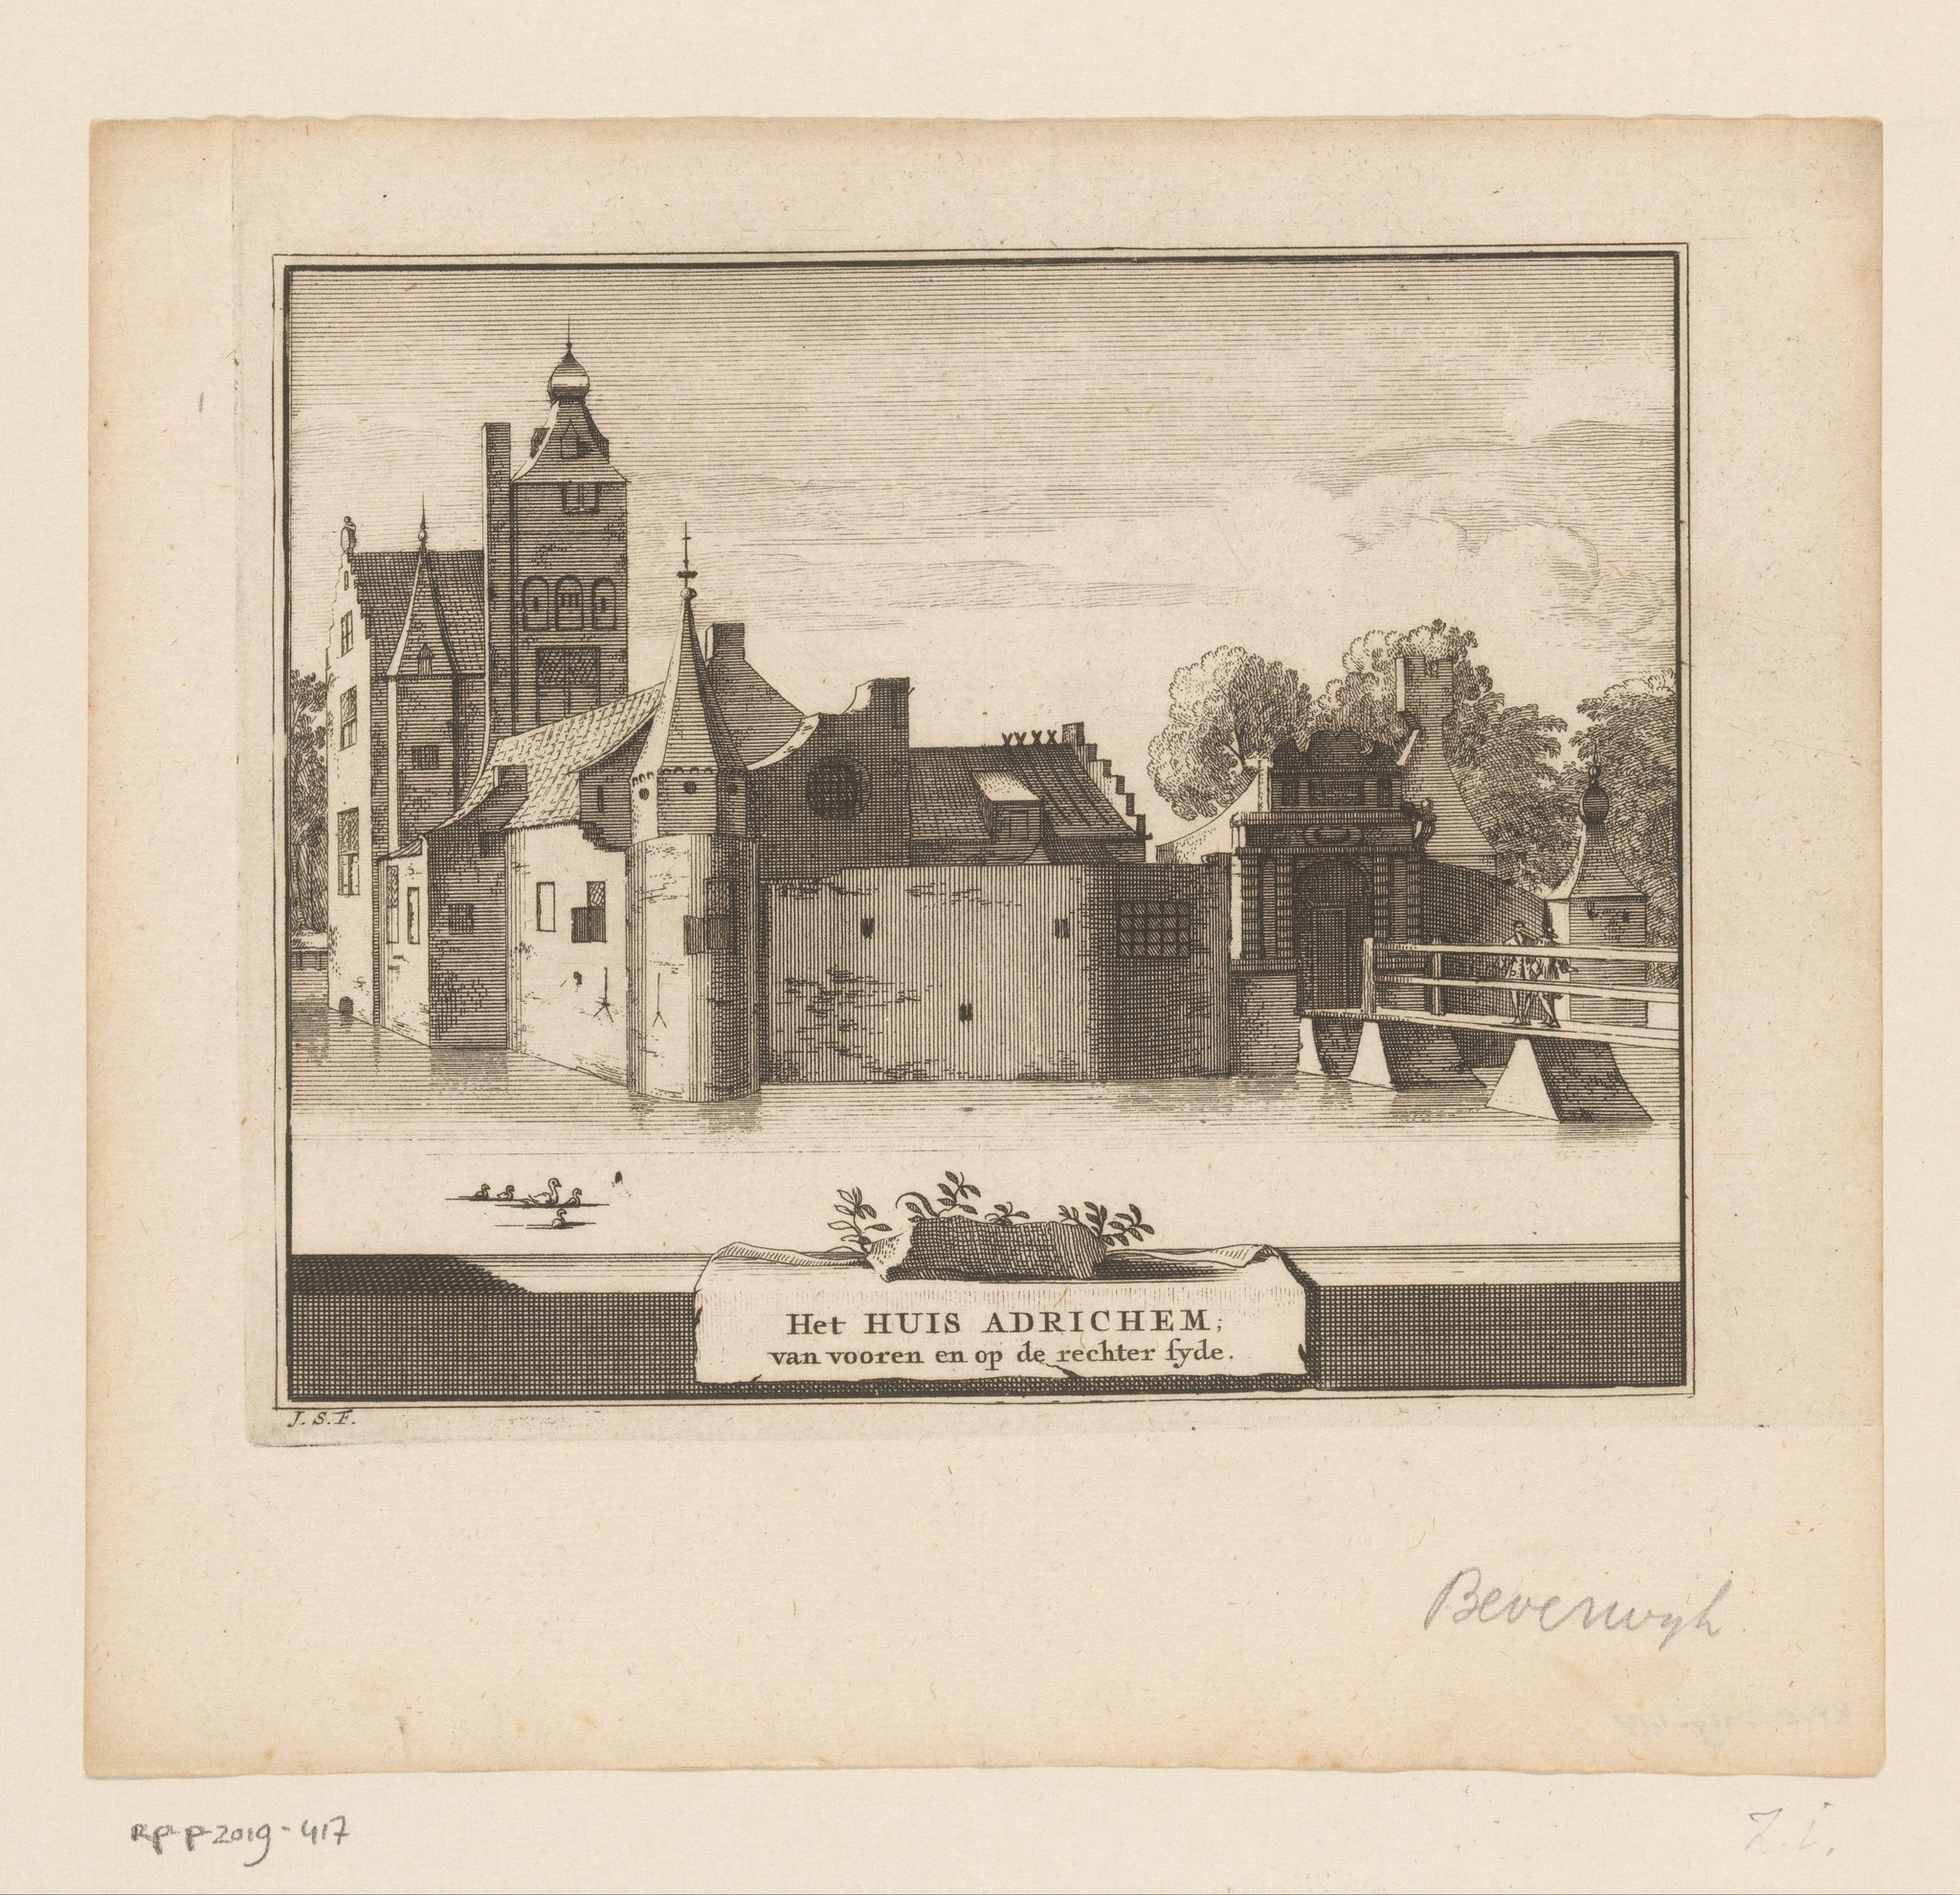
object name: print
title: Het Huis Adrichem, van vooren en op de rechter syde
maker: jacobus schijnvoet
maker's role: draughtsman, print maker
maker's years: 1685-1743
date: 1711-1774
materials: paper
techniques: etching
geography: amsterdam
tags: castle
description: Prent opgenomen in: Smids, Ludolph. Schatkamer der Nederlandsse[!] oudheden; of Woordenboek, behelsende Nederlands steden. Amsterdam: Pieter de Coup, 1711. Verscheen tevens in de heruitgave van voorgenoemd werk in 1737 en 1774. In 1721 verscheen er een uitgave met alleen de prenten: Nederlandsche oudheden, bestaande in zestig verbeeldingen (...) gelegen in Holland, 't Sticht van Utrecht en Gelderland enz. Amsterdam: Hendrik Bosch, 1721.